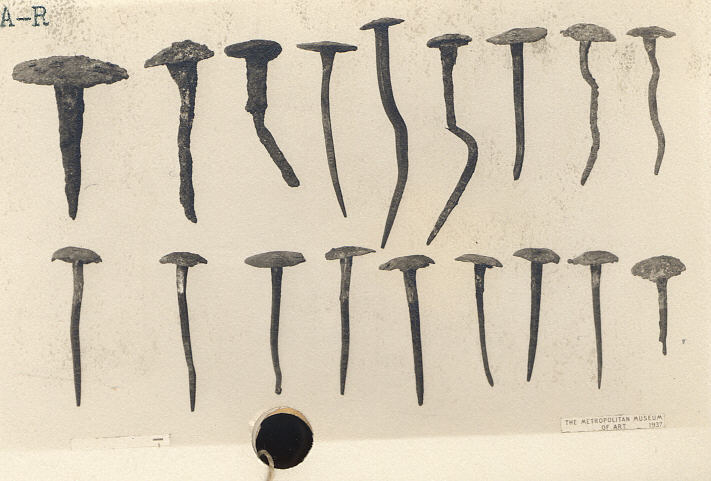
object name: nail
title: Nails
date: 601-700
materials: bronze, iron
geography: egypt